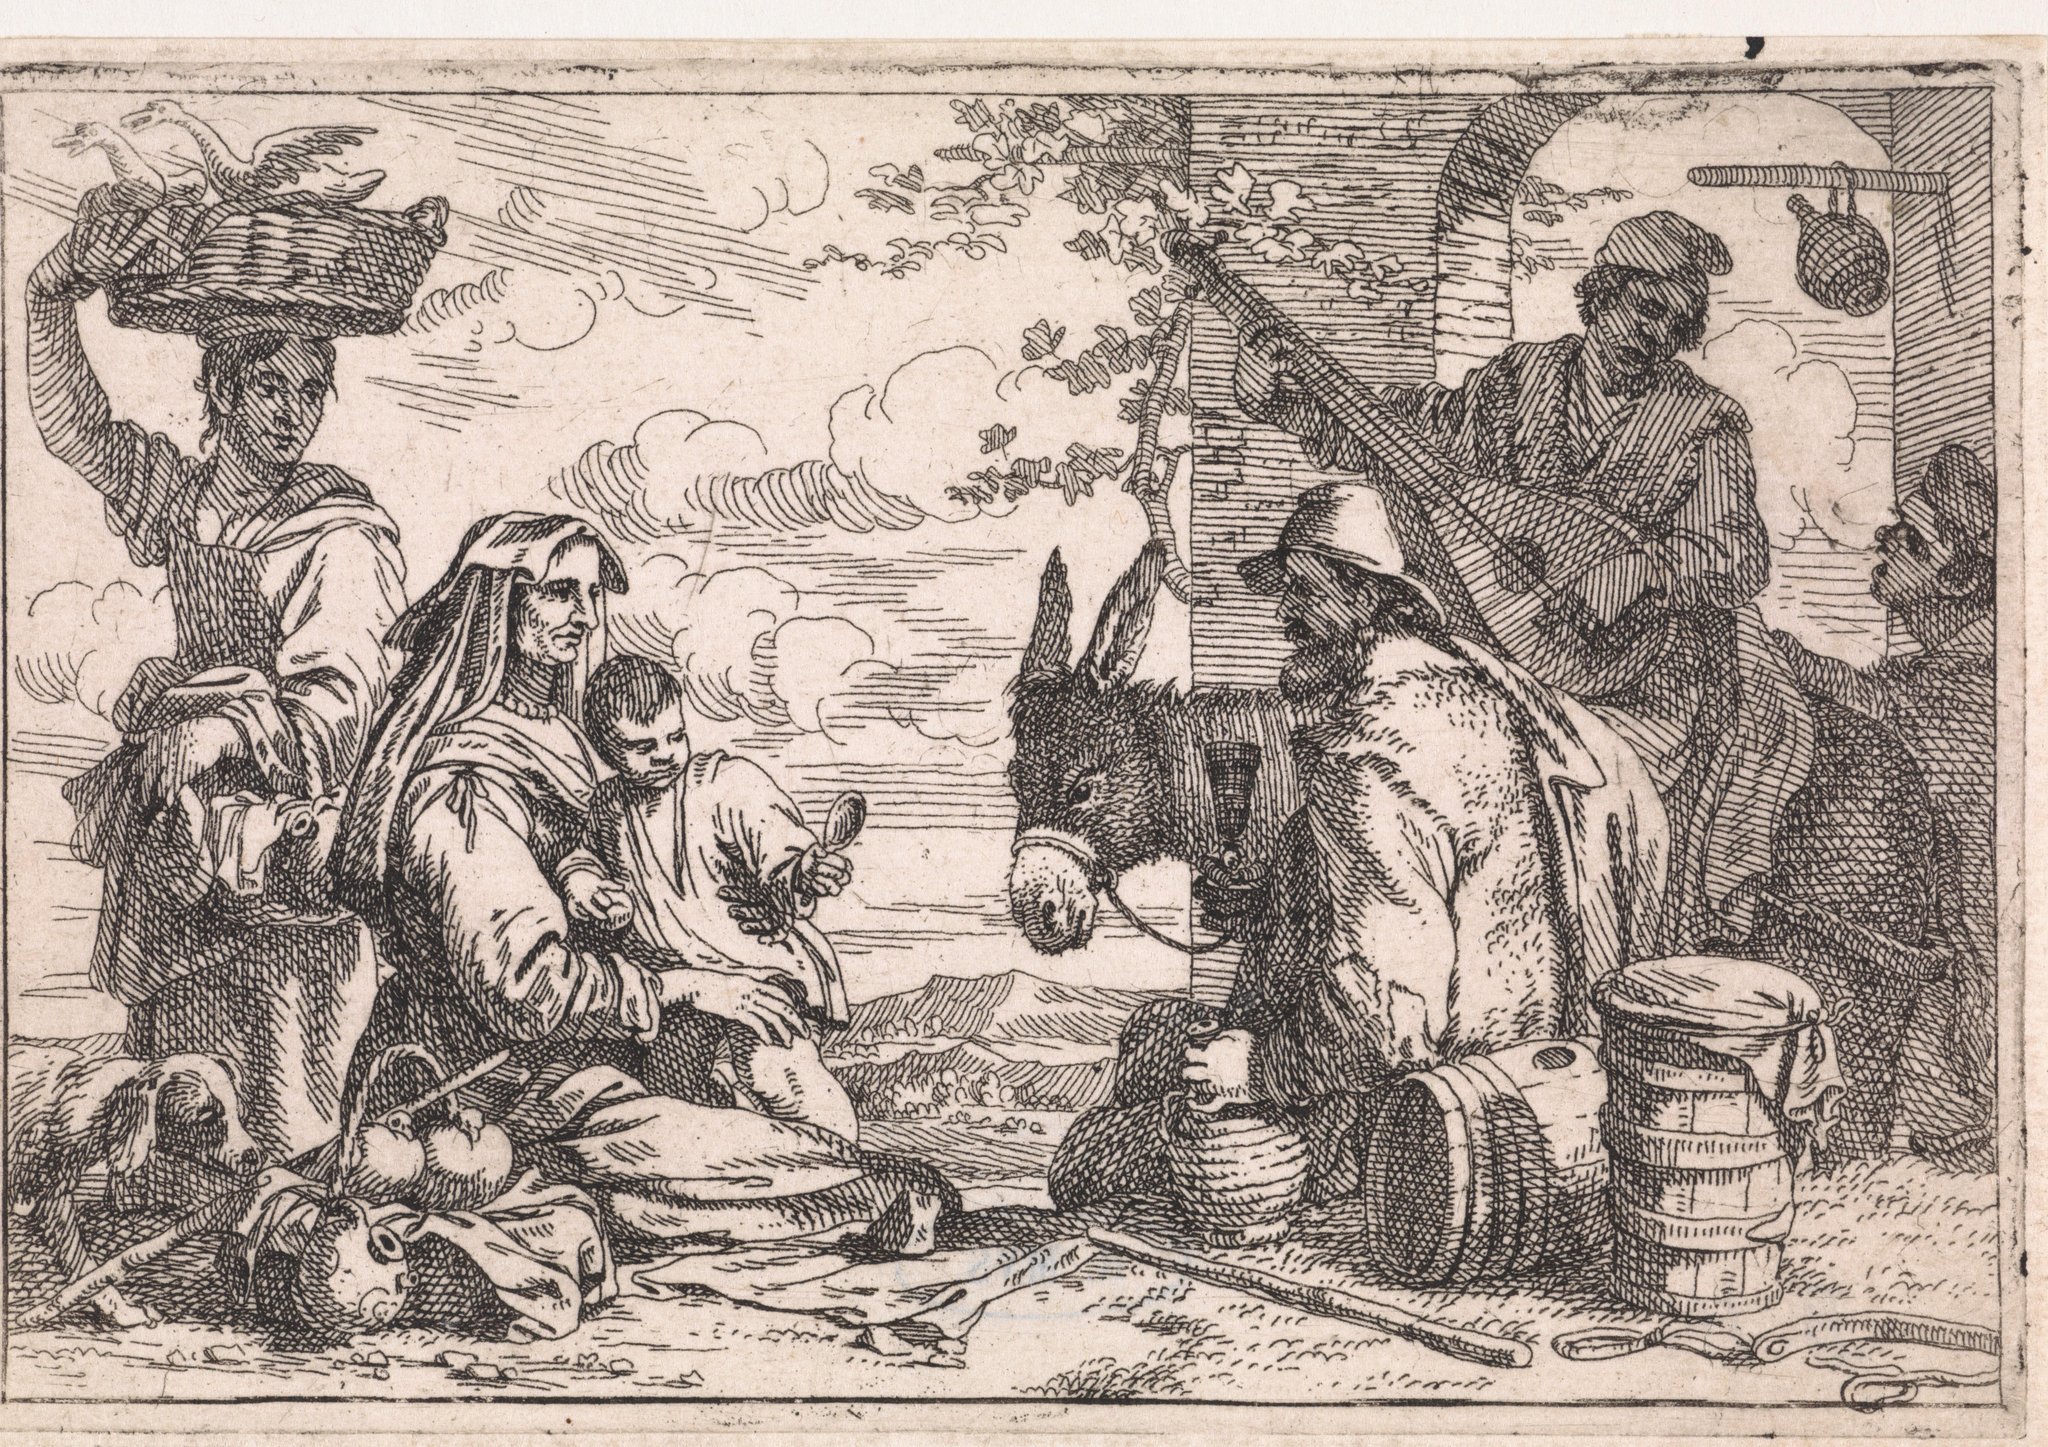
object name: print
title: Diverse genretaferelen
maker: jan baptist de wael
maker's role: print maker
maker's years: 1632-1669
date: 1642-1669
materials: paper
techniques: etching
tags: cithern, mandolin, guitar, balalaika - cc - out of doors, ass, donkey, (traveller) resting in the open air, dog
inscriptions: collector's mark: Lugt 2228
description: Een man is in gesprek met een vrouw die een kind op schoot heeft. Een hond snuffelt aan haar spullen. Langs hen loopt een vrouw, op haar hoofd draagt zij een mand met eenden erin. Een man die op een colacione (een langshalsluit) speelt op een ezel rijdt voorbij.